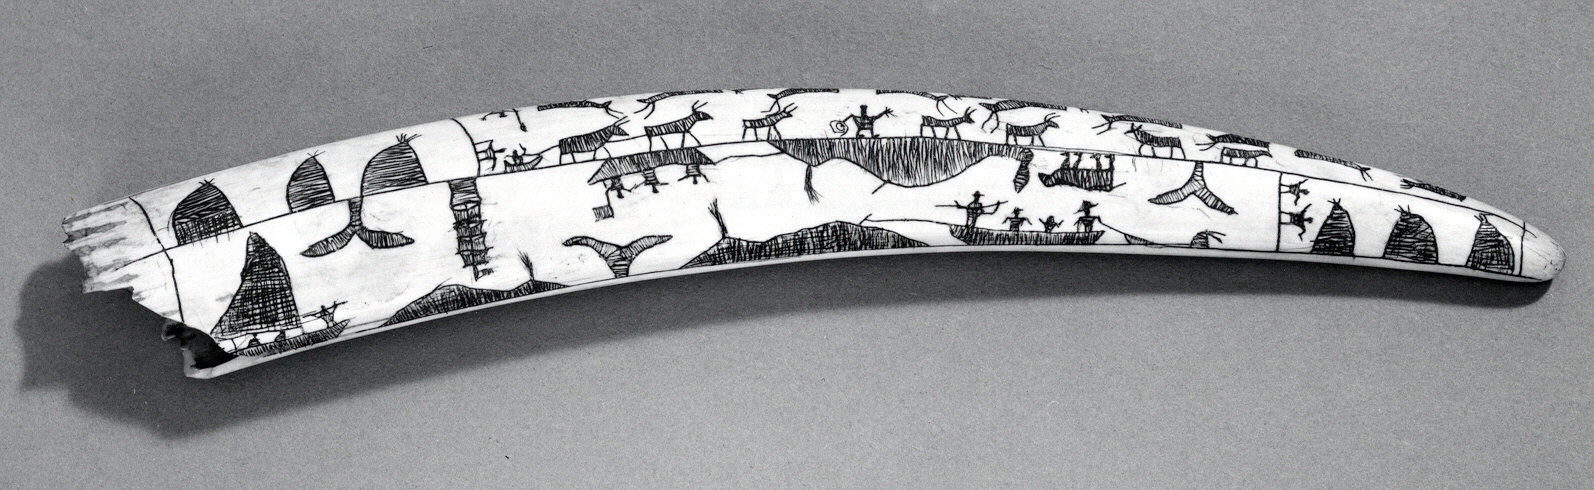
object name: tusk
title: Engraved Ivory Tusk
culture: inuit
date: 1880-1890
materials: ivory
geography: united states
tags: human figures,fish,boats